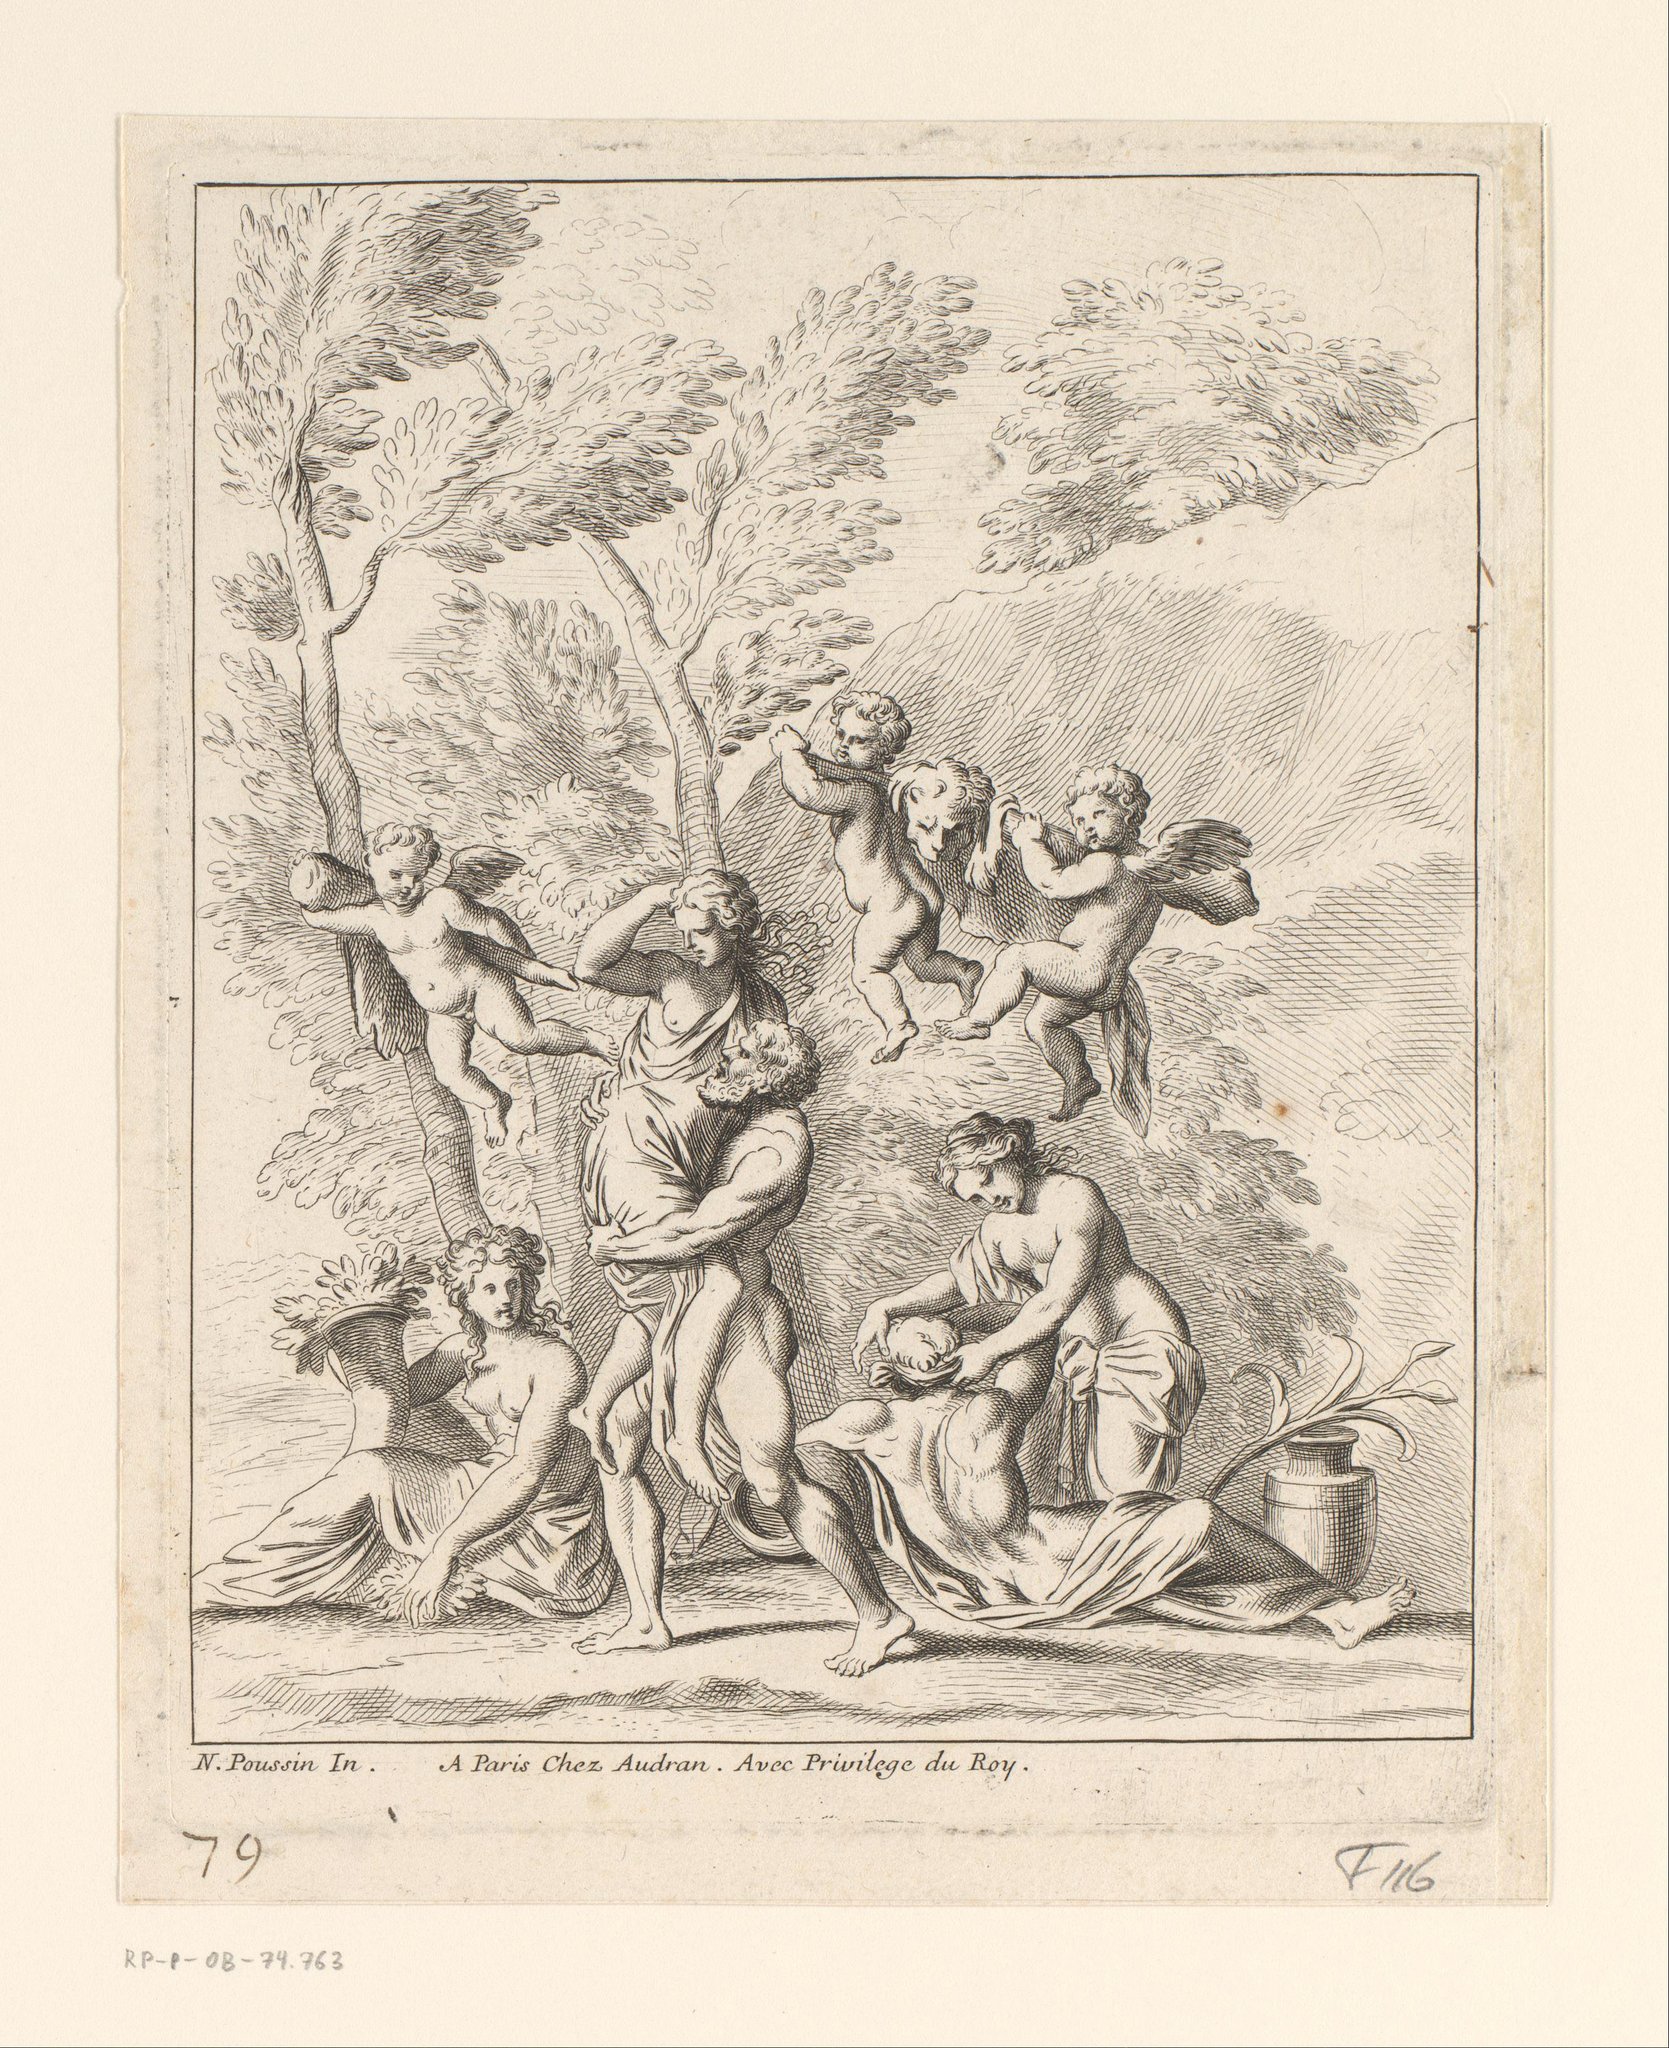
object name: print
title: Hercules draagt Deianeira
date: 1650-1703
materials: paper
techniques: engraving, etching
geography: paris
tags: hercules in love with deianira, daughter of oeneus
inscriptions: number: ‘79’, collector's mark: Lugt 240